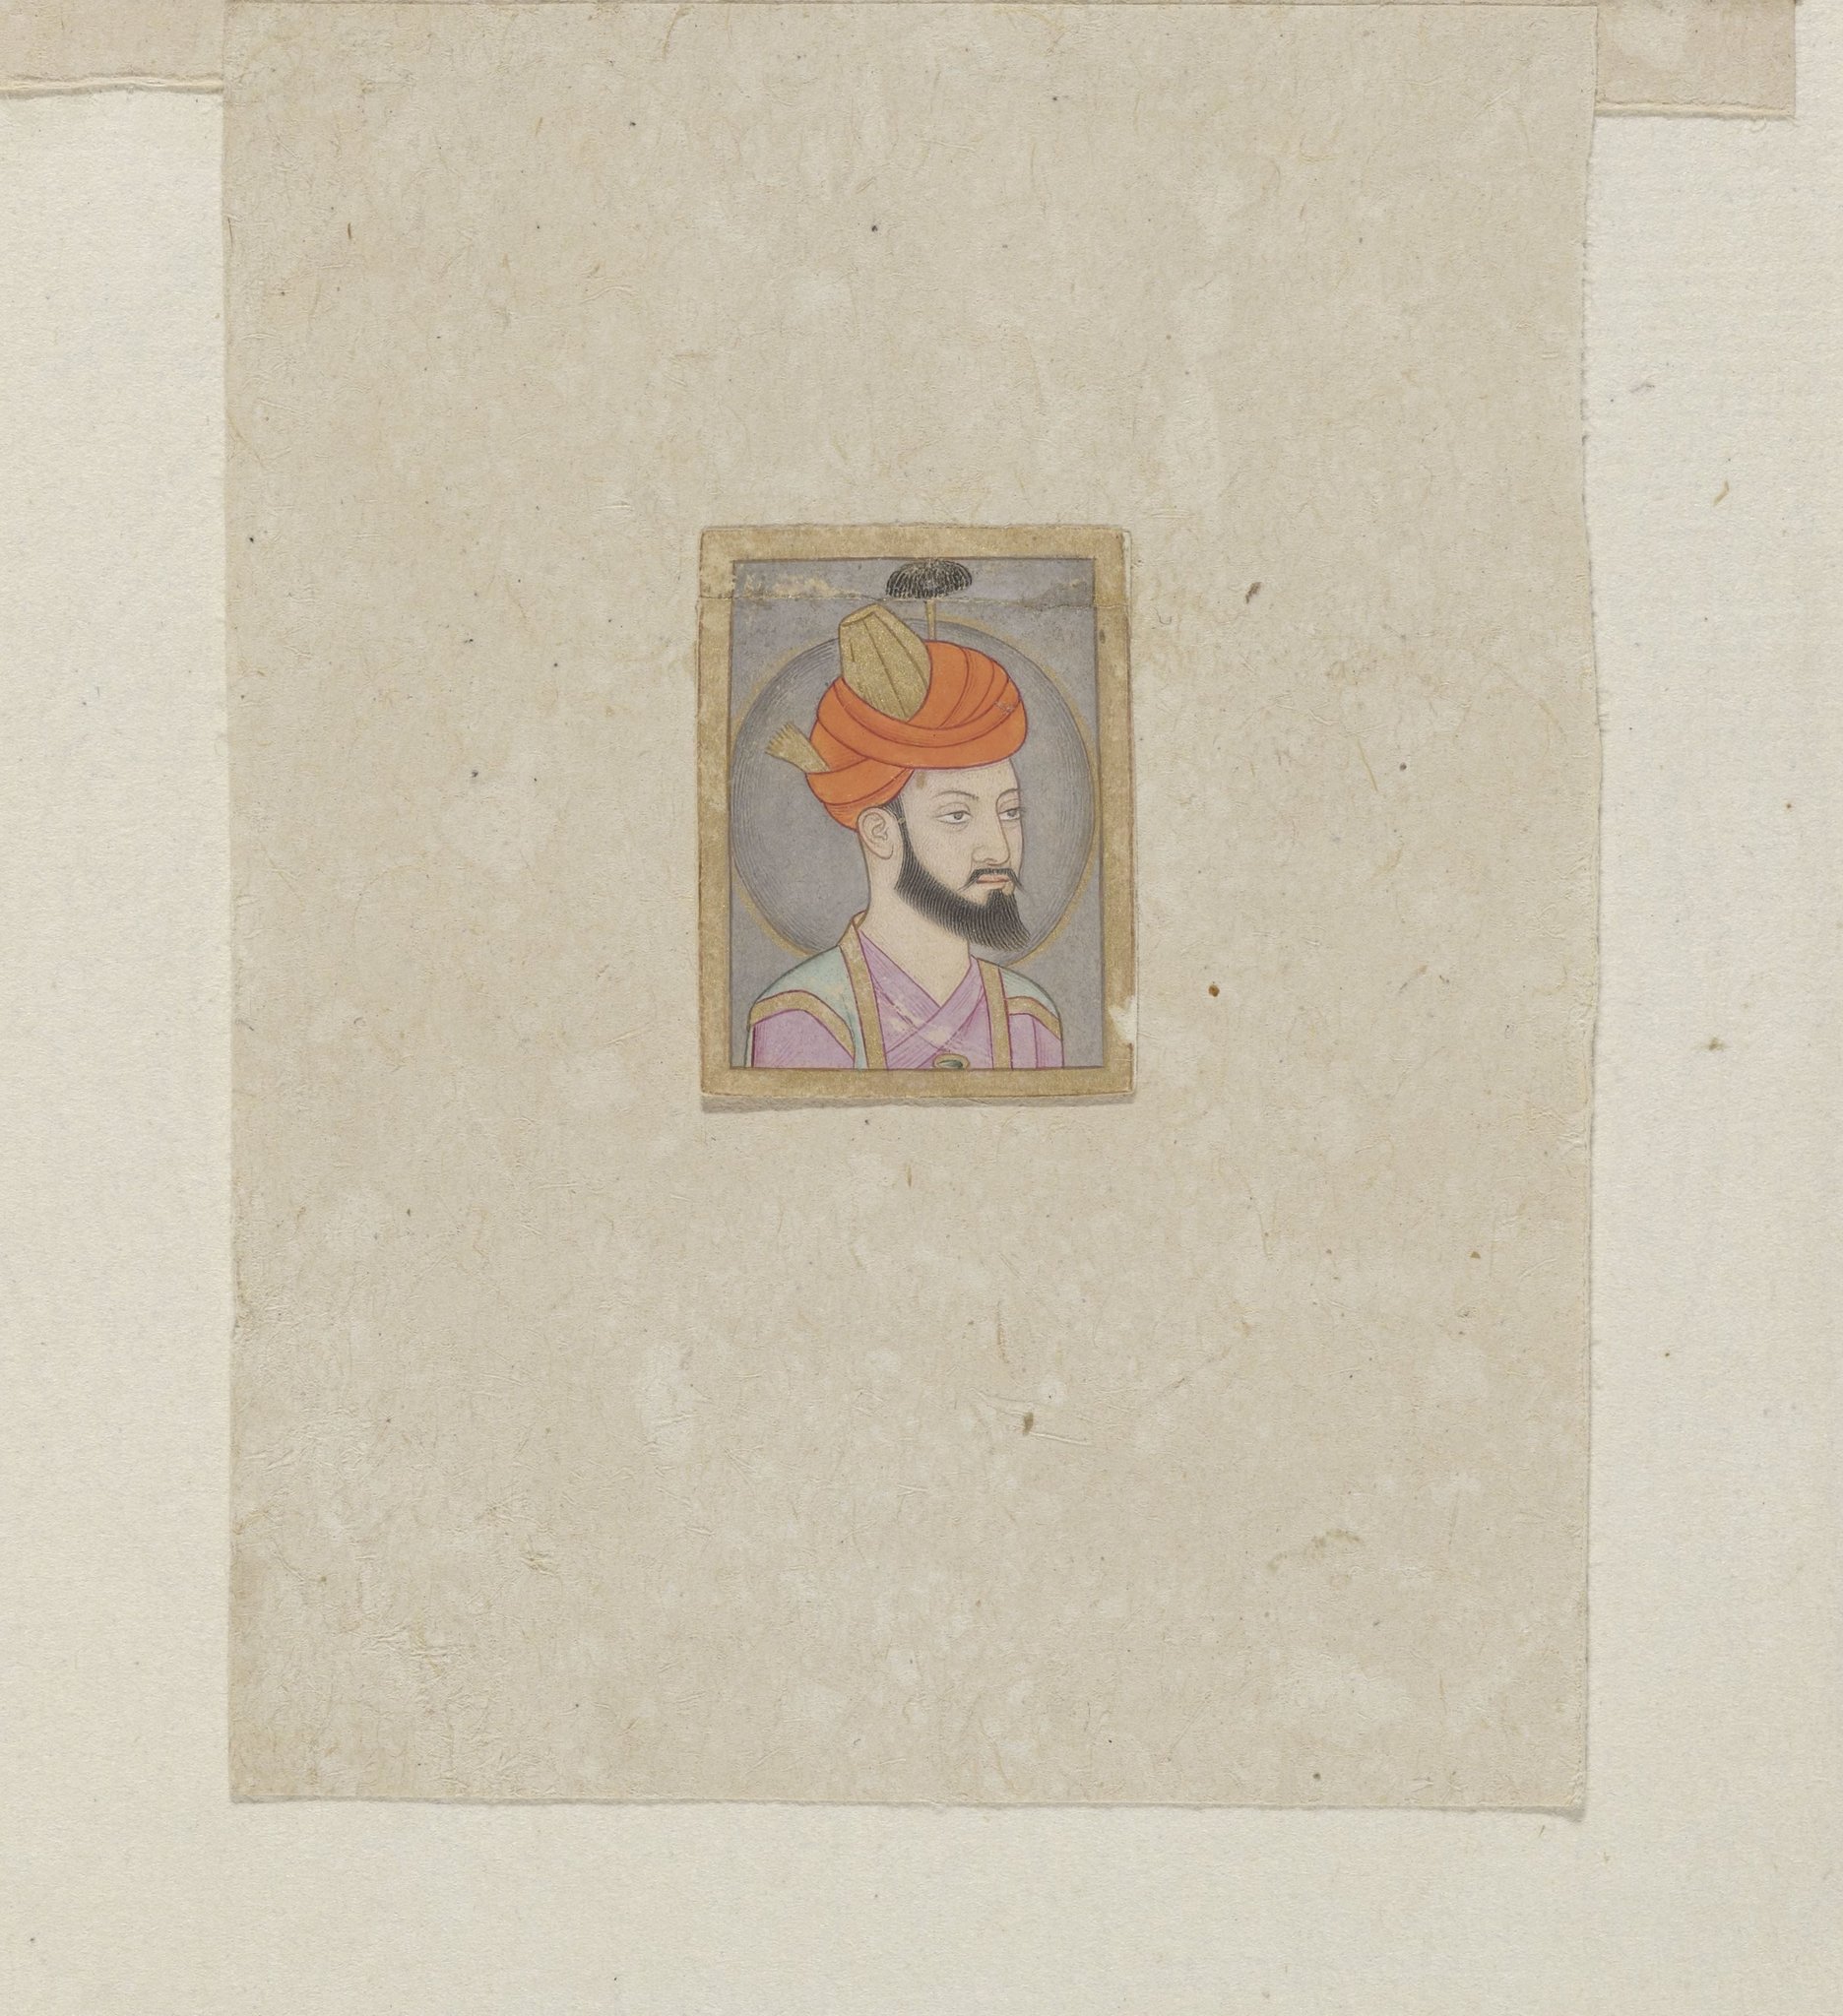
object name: drawing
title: Munsja sultan mhamod derde koning van Indostan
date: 1675-1725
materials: paper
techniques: drawing, writing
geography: deccan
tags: adrianus canter visscher, historical persons, ruler, sovereign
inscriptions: caption: ‘Munsja sultaan mhamod derde koning van Indostan / van sijn regering en dood, en van wien gesproken, is niets / te vinden’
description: Tekening uit het manuscript van de VOC dienaar Adrianus Canter Visscher met achterin achtentwintig Indiase miniaturen en twee kaarten van plaatsen aan de Coromandelkust. De tekst bestaat uit twee delen: een geschiedenis van het Mogolrijk en de VOC-vestigingen aan de Coromandelkust; daarna volgt een advies aan de Heren XVII over de economische situatie van de VOC in de Coromandel.